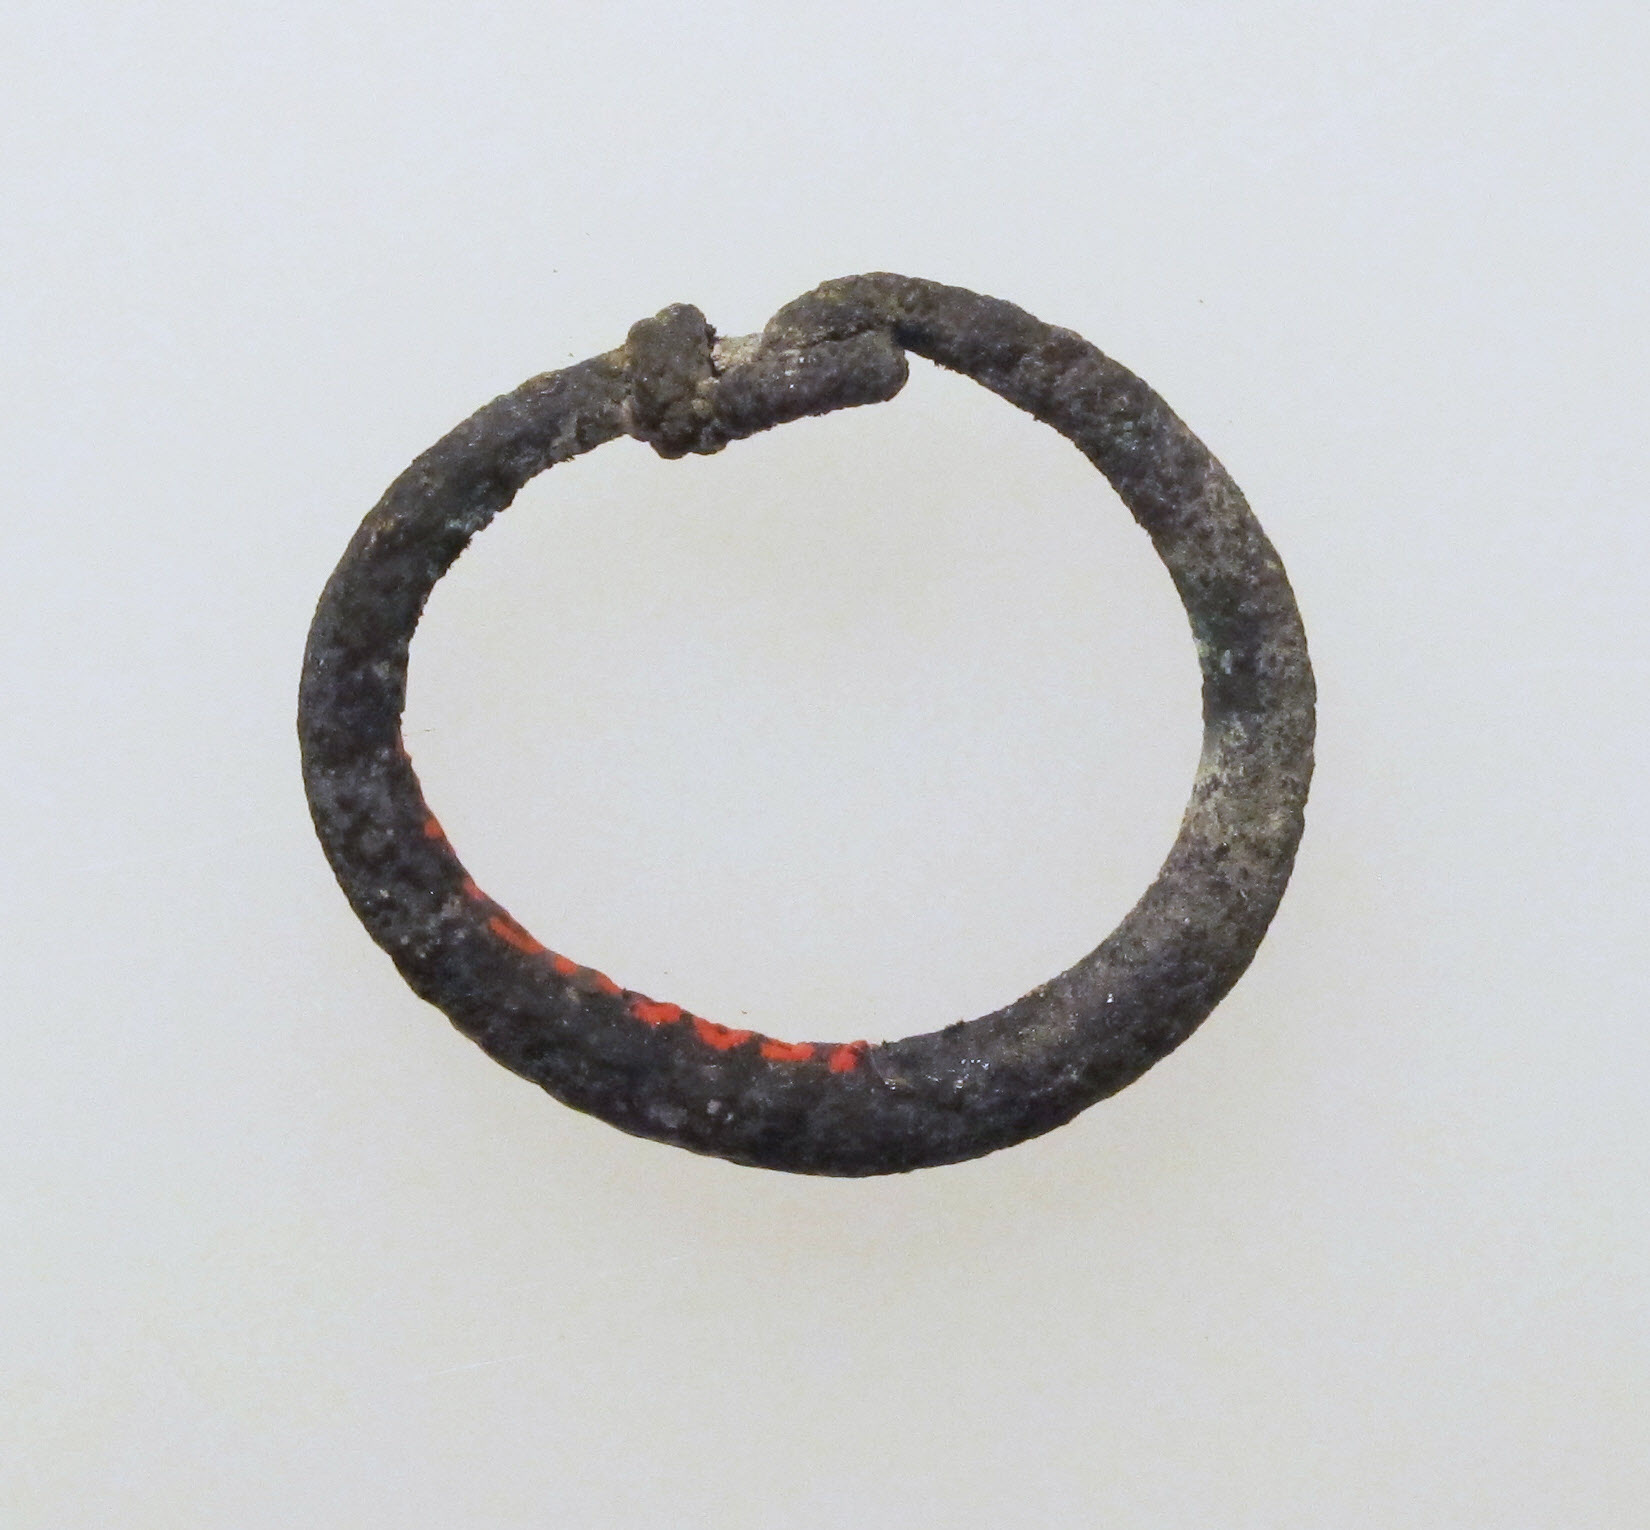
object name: earring loop type, plain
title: Earring-loop type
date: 7000 BCE-330 CE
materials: silver